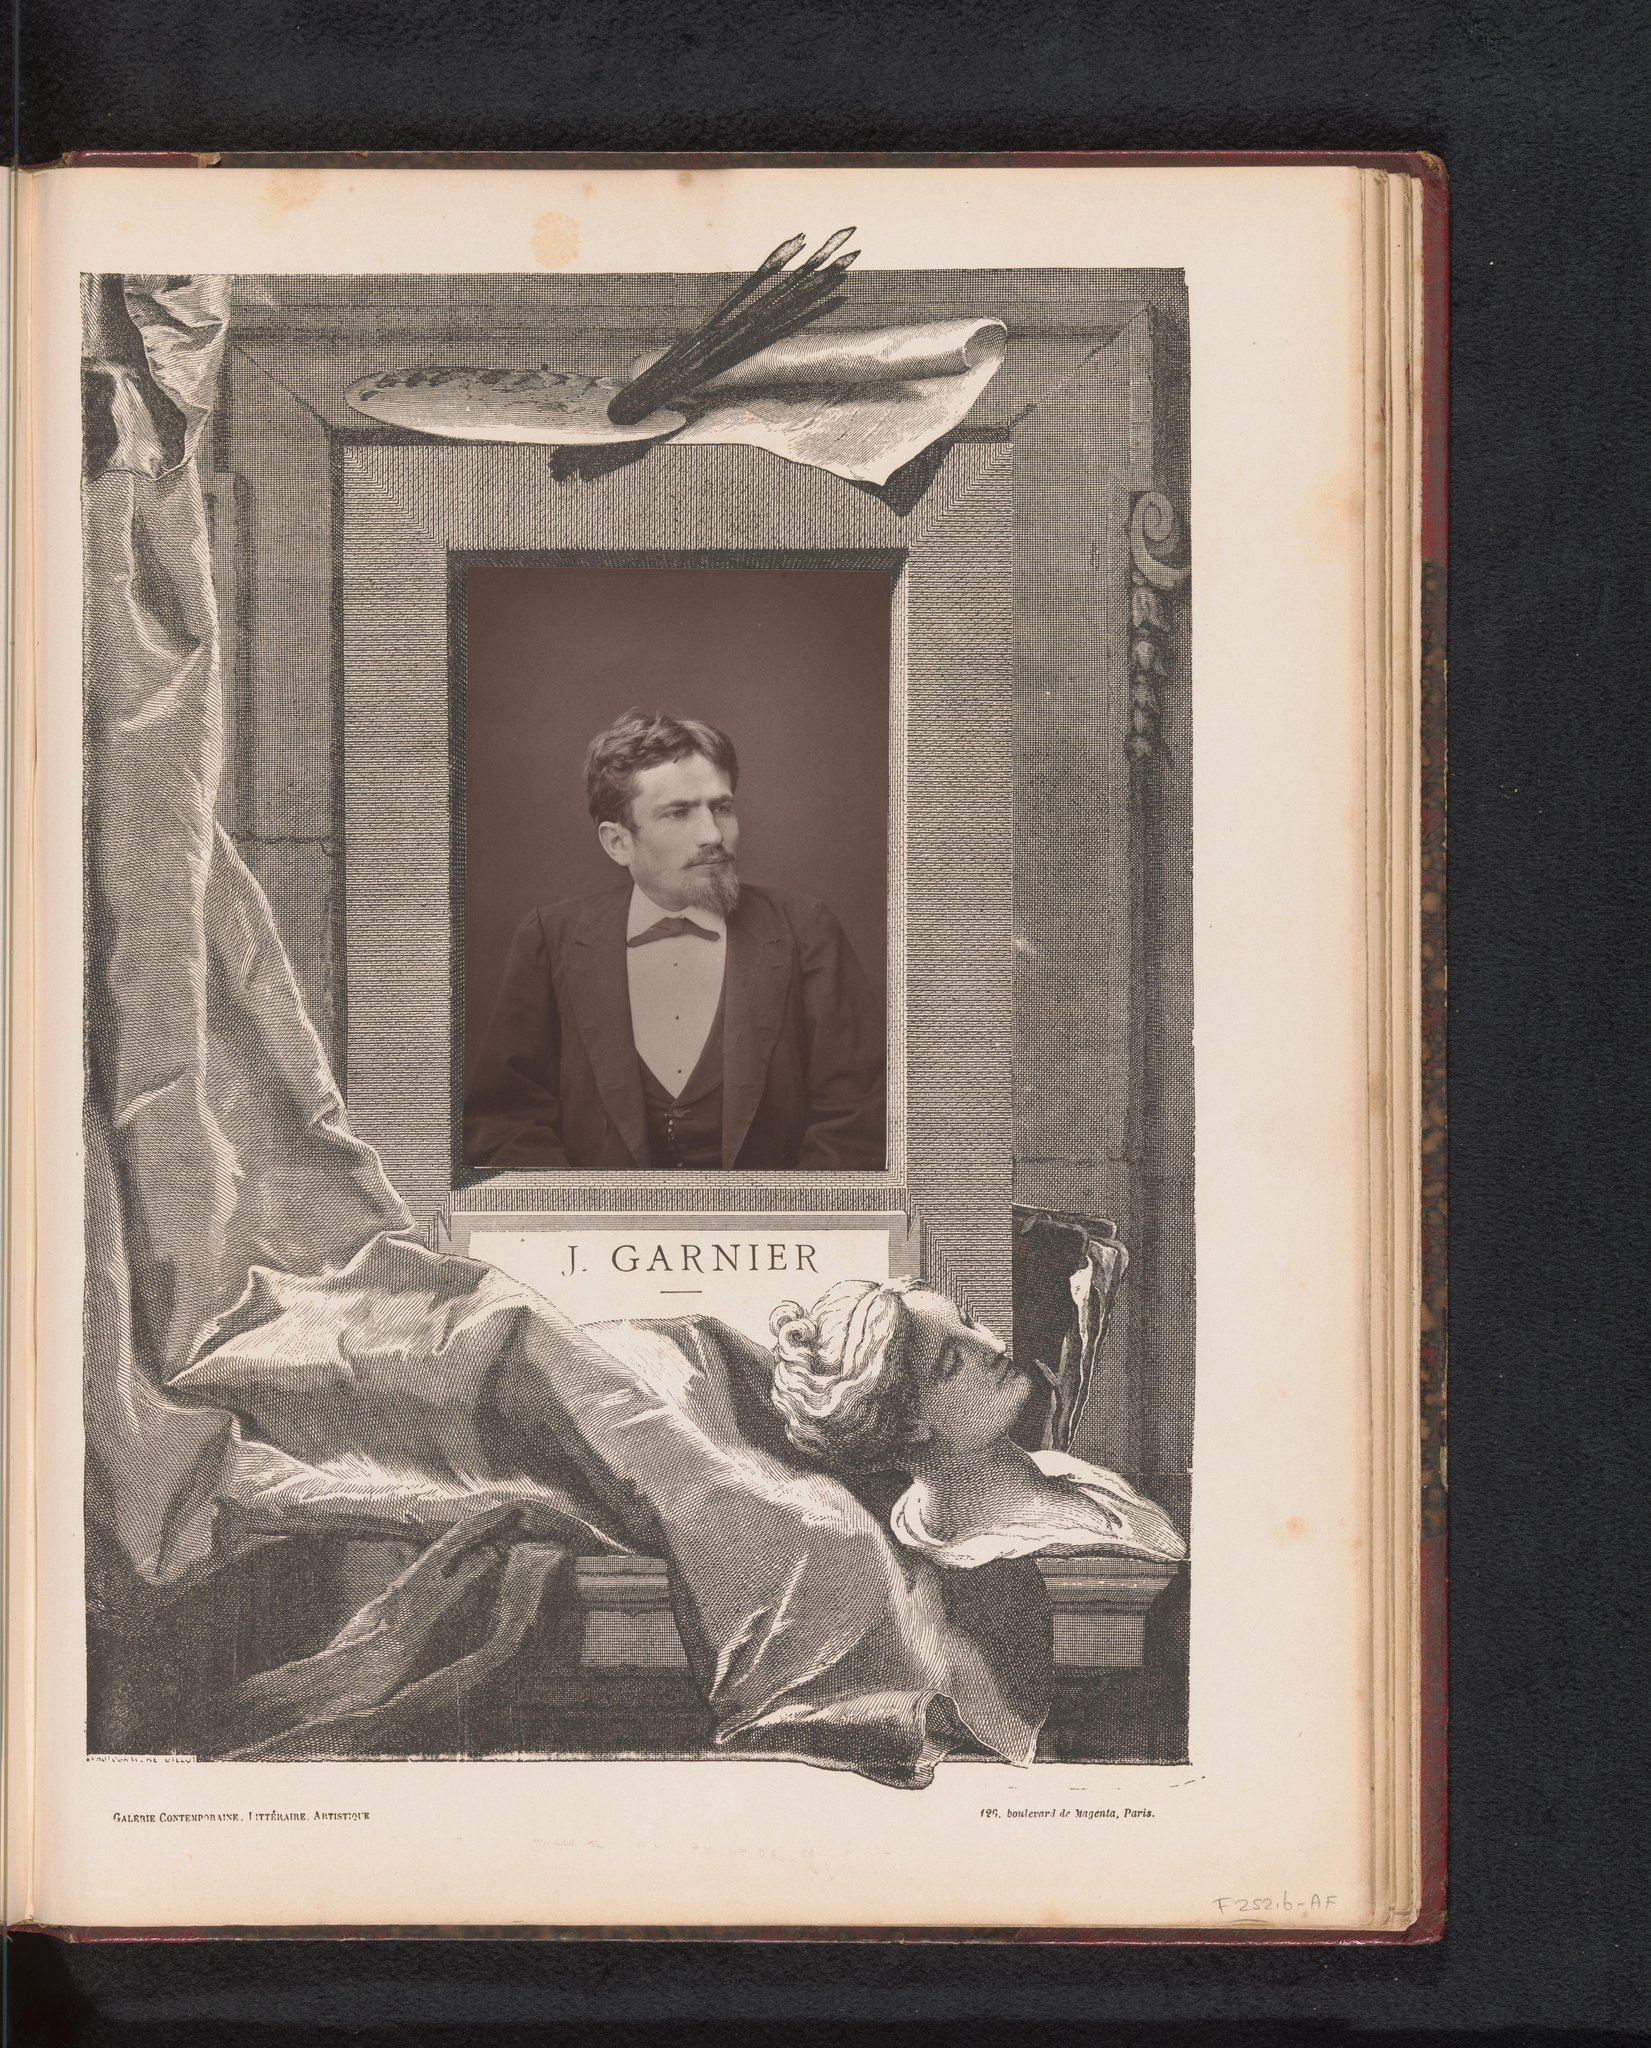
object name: page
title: Portret van Jules-Arsène Garnier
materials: paper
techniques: printing block, woodburytype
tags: painter, jules-arsène garnier, adult man, historical persons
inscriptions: inscription: ‘Galerie Contemporaine, Littéraire, Artistique/ 126, boulevard de Magenta, Paris’